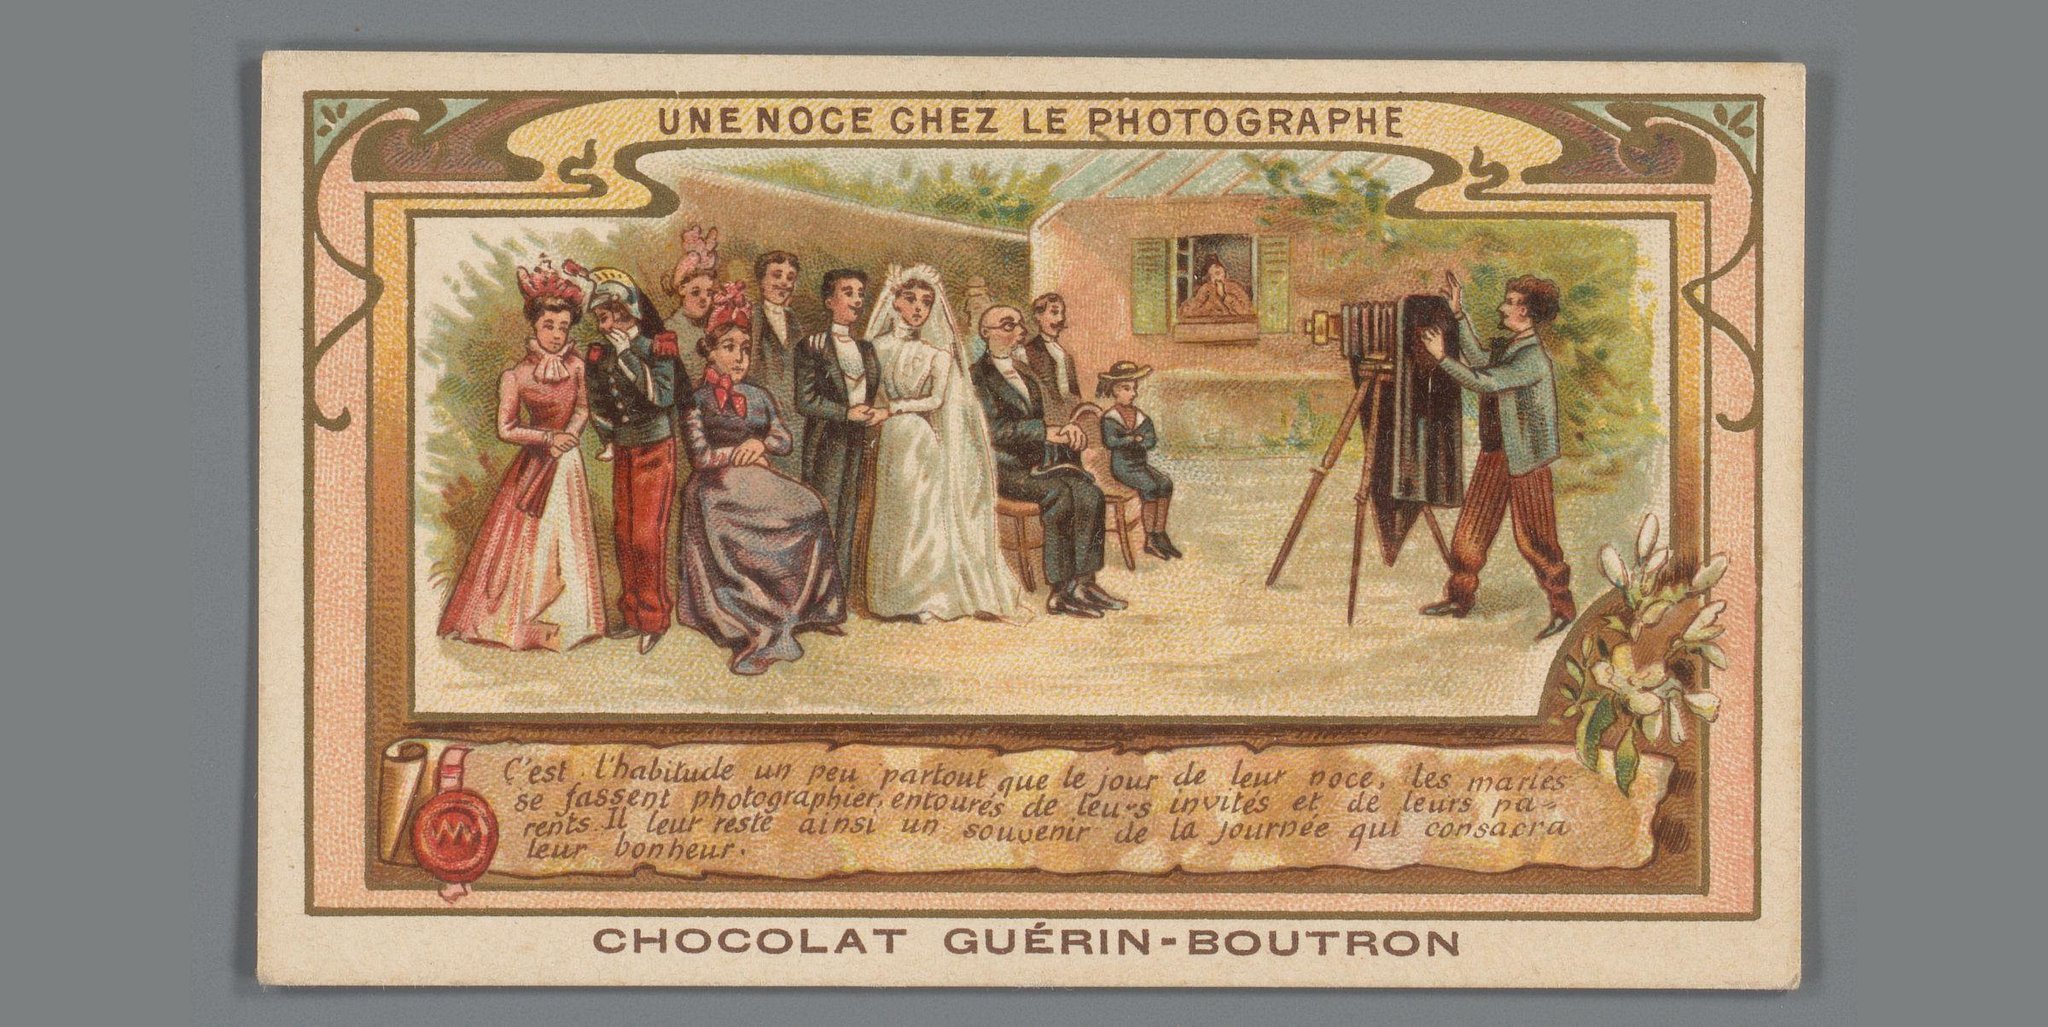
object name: promotional material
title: Bruidspaar bij een fotograaf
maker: Anonymous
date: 1900-1930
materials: cardboard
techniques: lithograph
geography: paris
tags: civil marriage ceremony, taking photographs - cc - out of doors